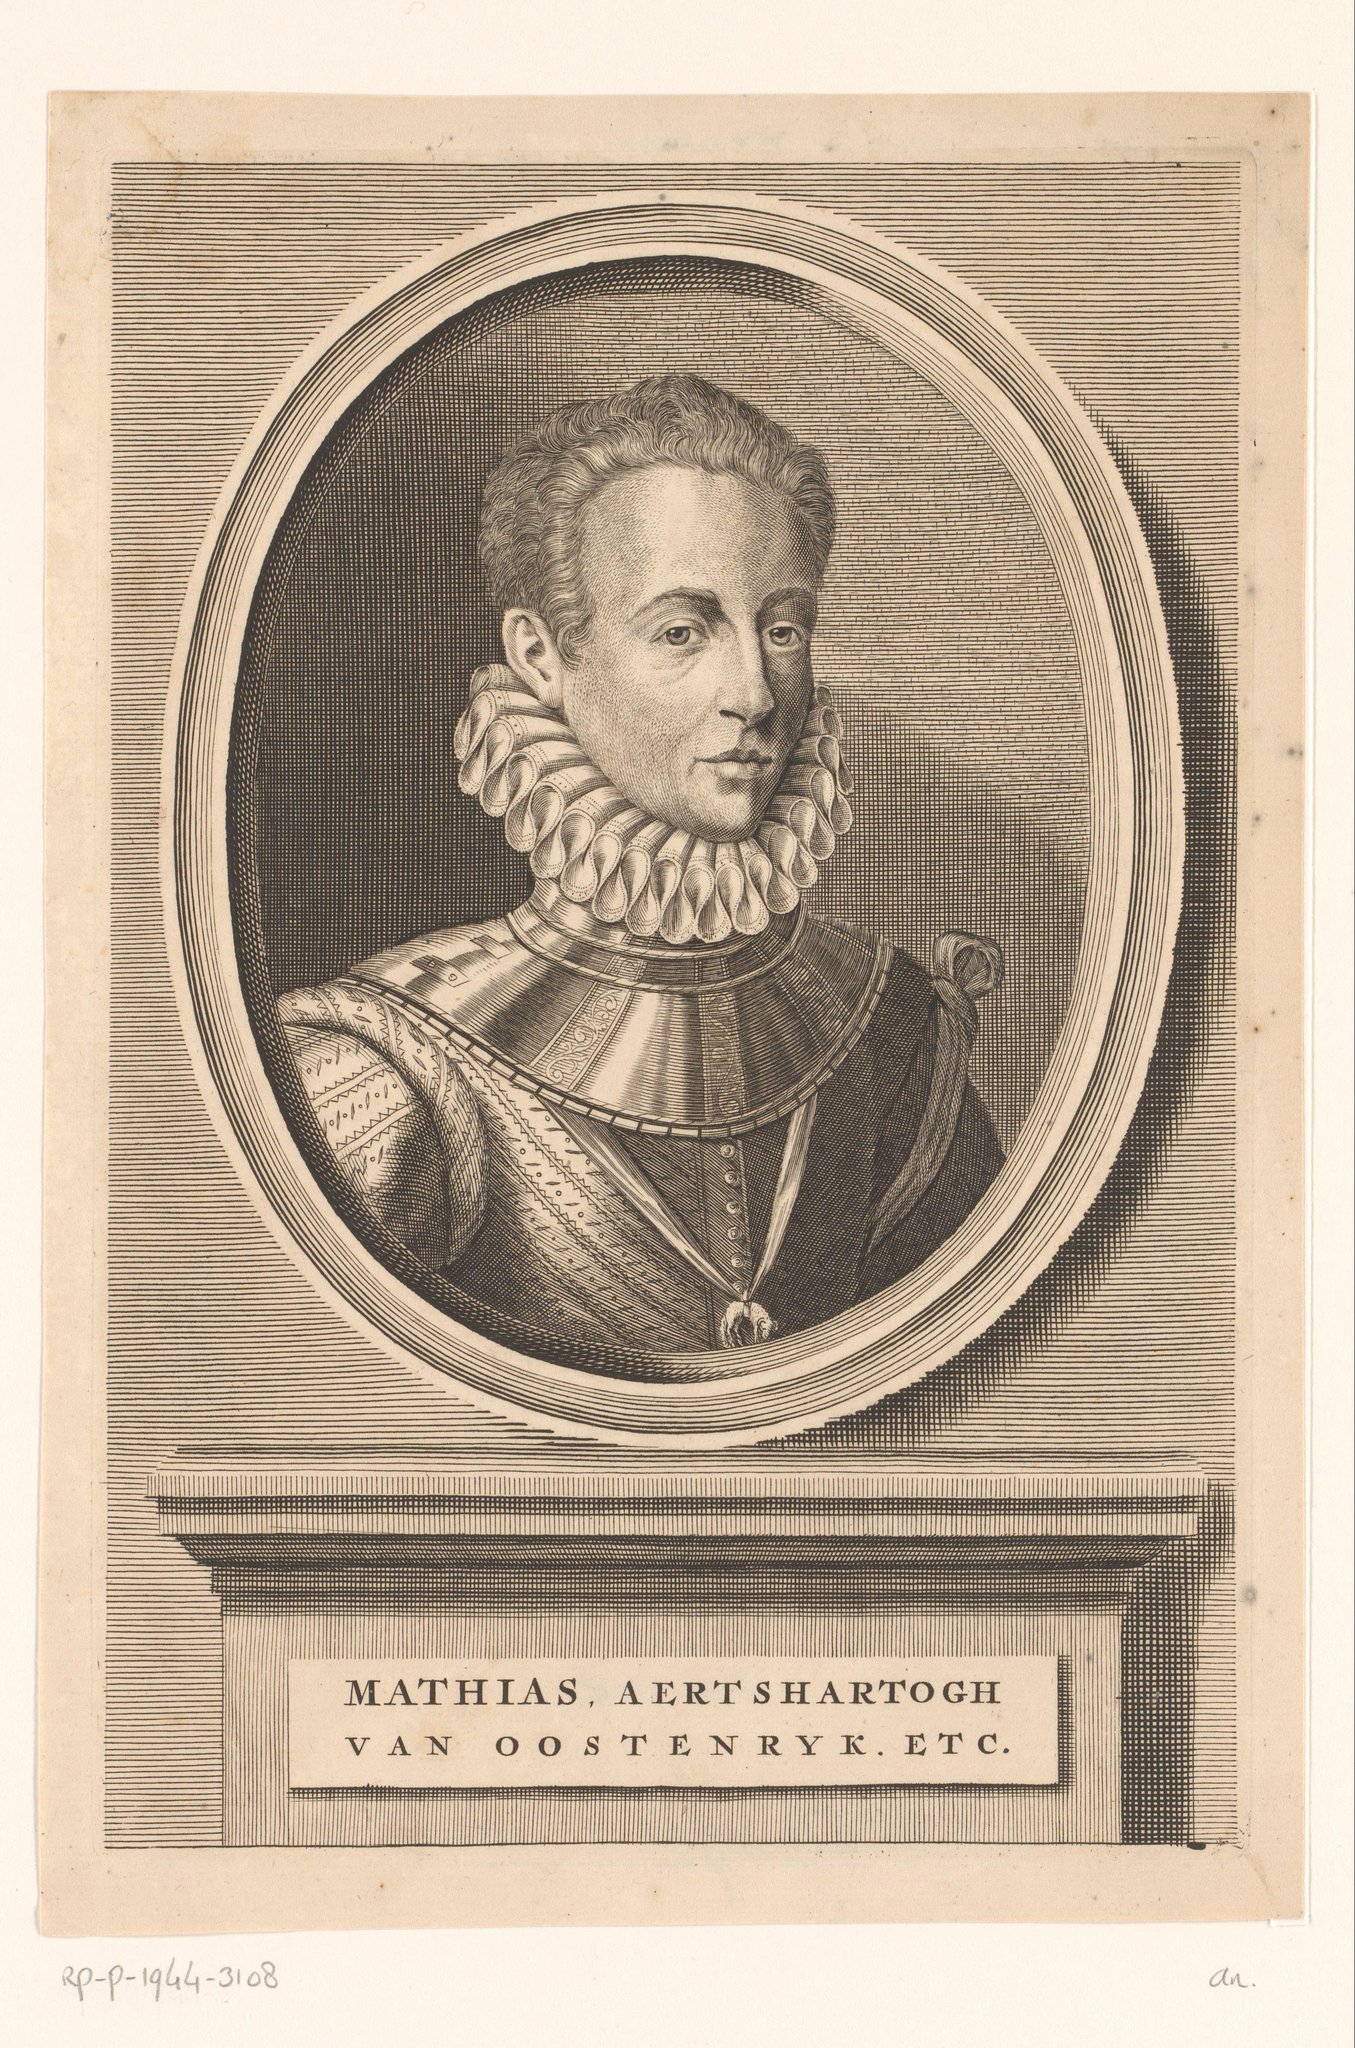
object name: print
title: Portret van keizer Matthias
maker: Anonymous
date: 1679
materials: paper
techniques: engraving, etching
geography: northern netherlands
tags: matthias van oostenrijk (rooms-duits keizer), ornament ~ medallion, historical persons, emperor, knighthood order of the golden fleece - insignia of a knighthood order, e.g.: badge, chain (with name of order)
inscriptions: collector's mark: Lugt 2228, number: ‘No. 692’, inscription: ‘Reeds bij Franken aanwezig/ Gm’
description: Prent waarschijnlijk uit: Bor, Pieter Christiaansz. Oorsprongk, begin, en vervolgh der Nederlandsche oorlogen (...). Amsterdam: weduwe Joannes van Someren et al., 1679. Latere staat gebruikt in: Le Clerc, Jean. Geschiedenissen der Vereenigde Nederlanden. Amsterdam: Zacharias Chatelain, 1730, dl. 1.